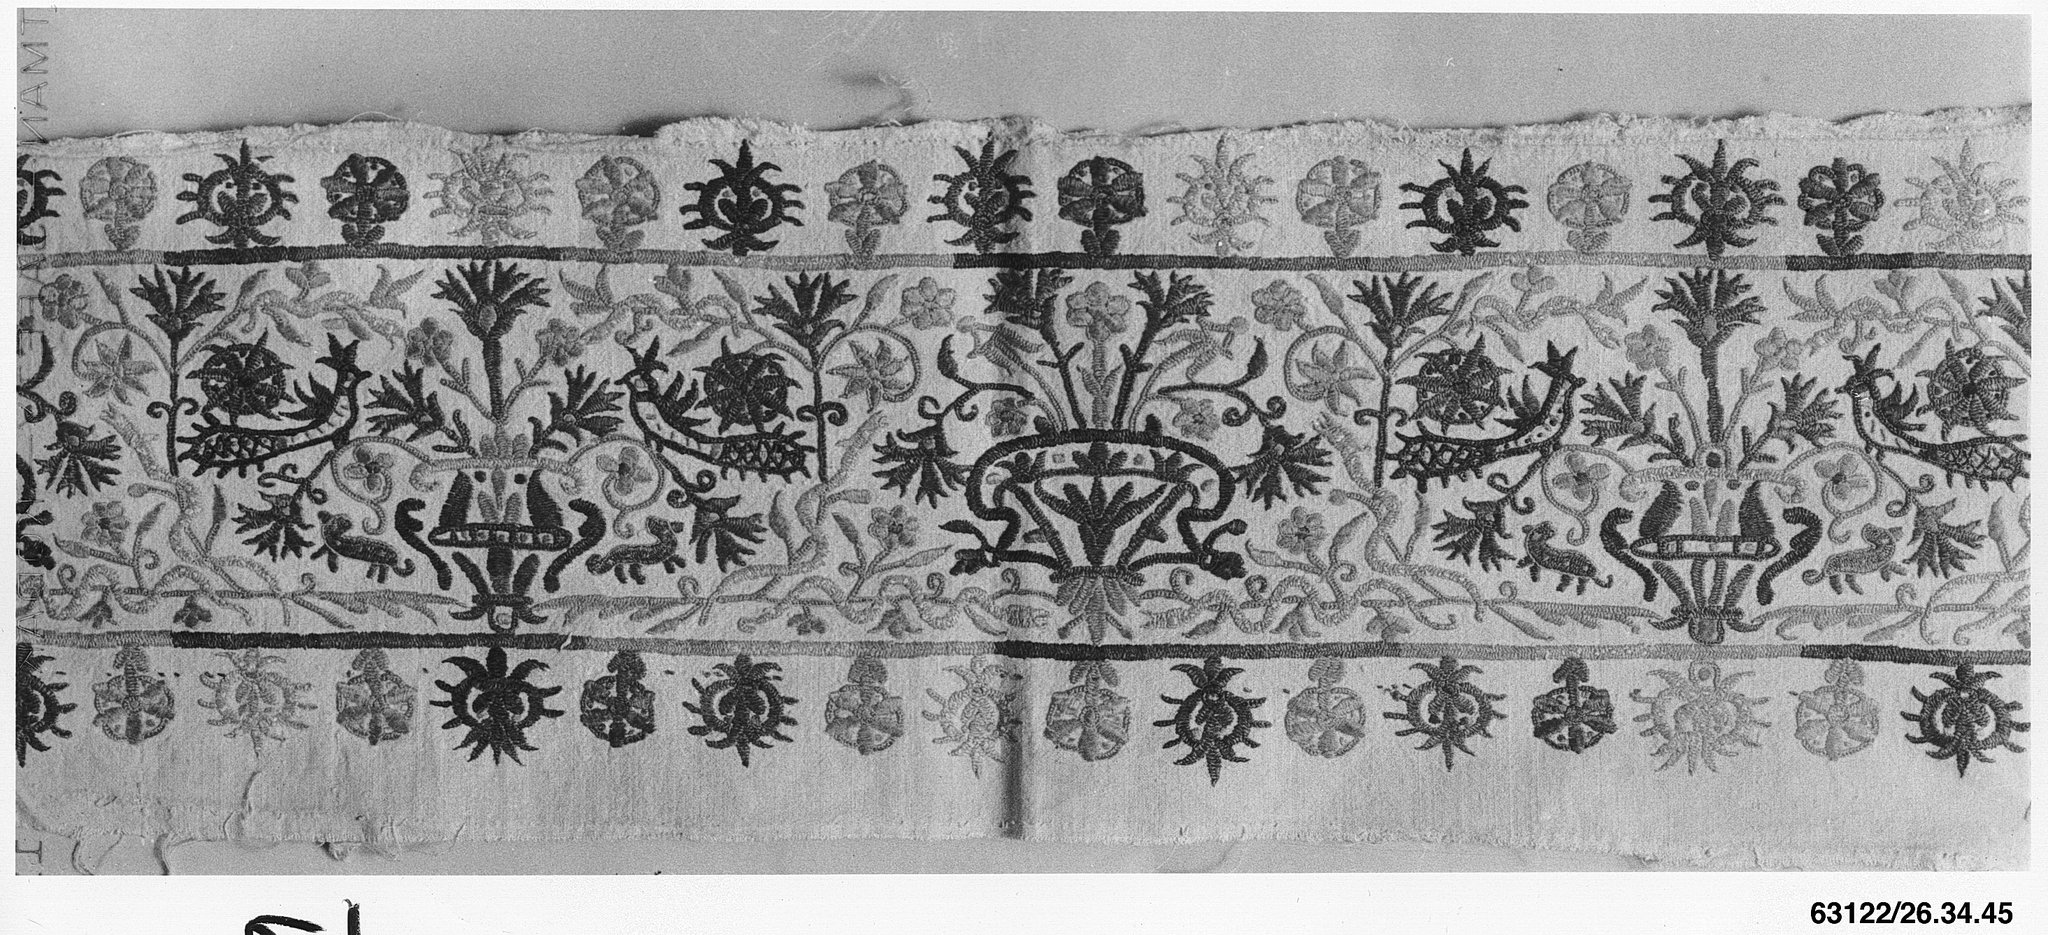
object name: border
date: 1701-1800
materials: linen, silk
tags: birds,flowers